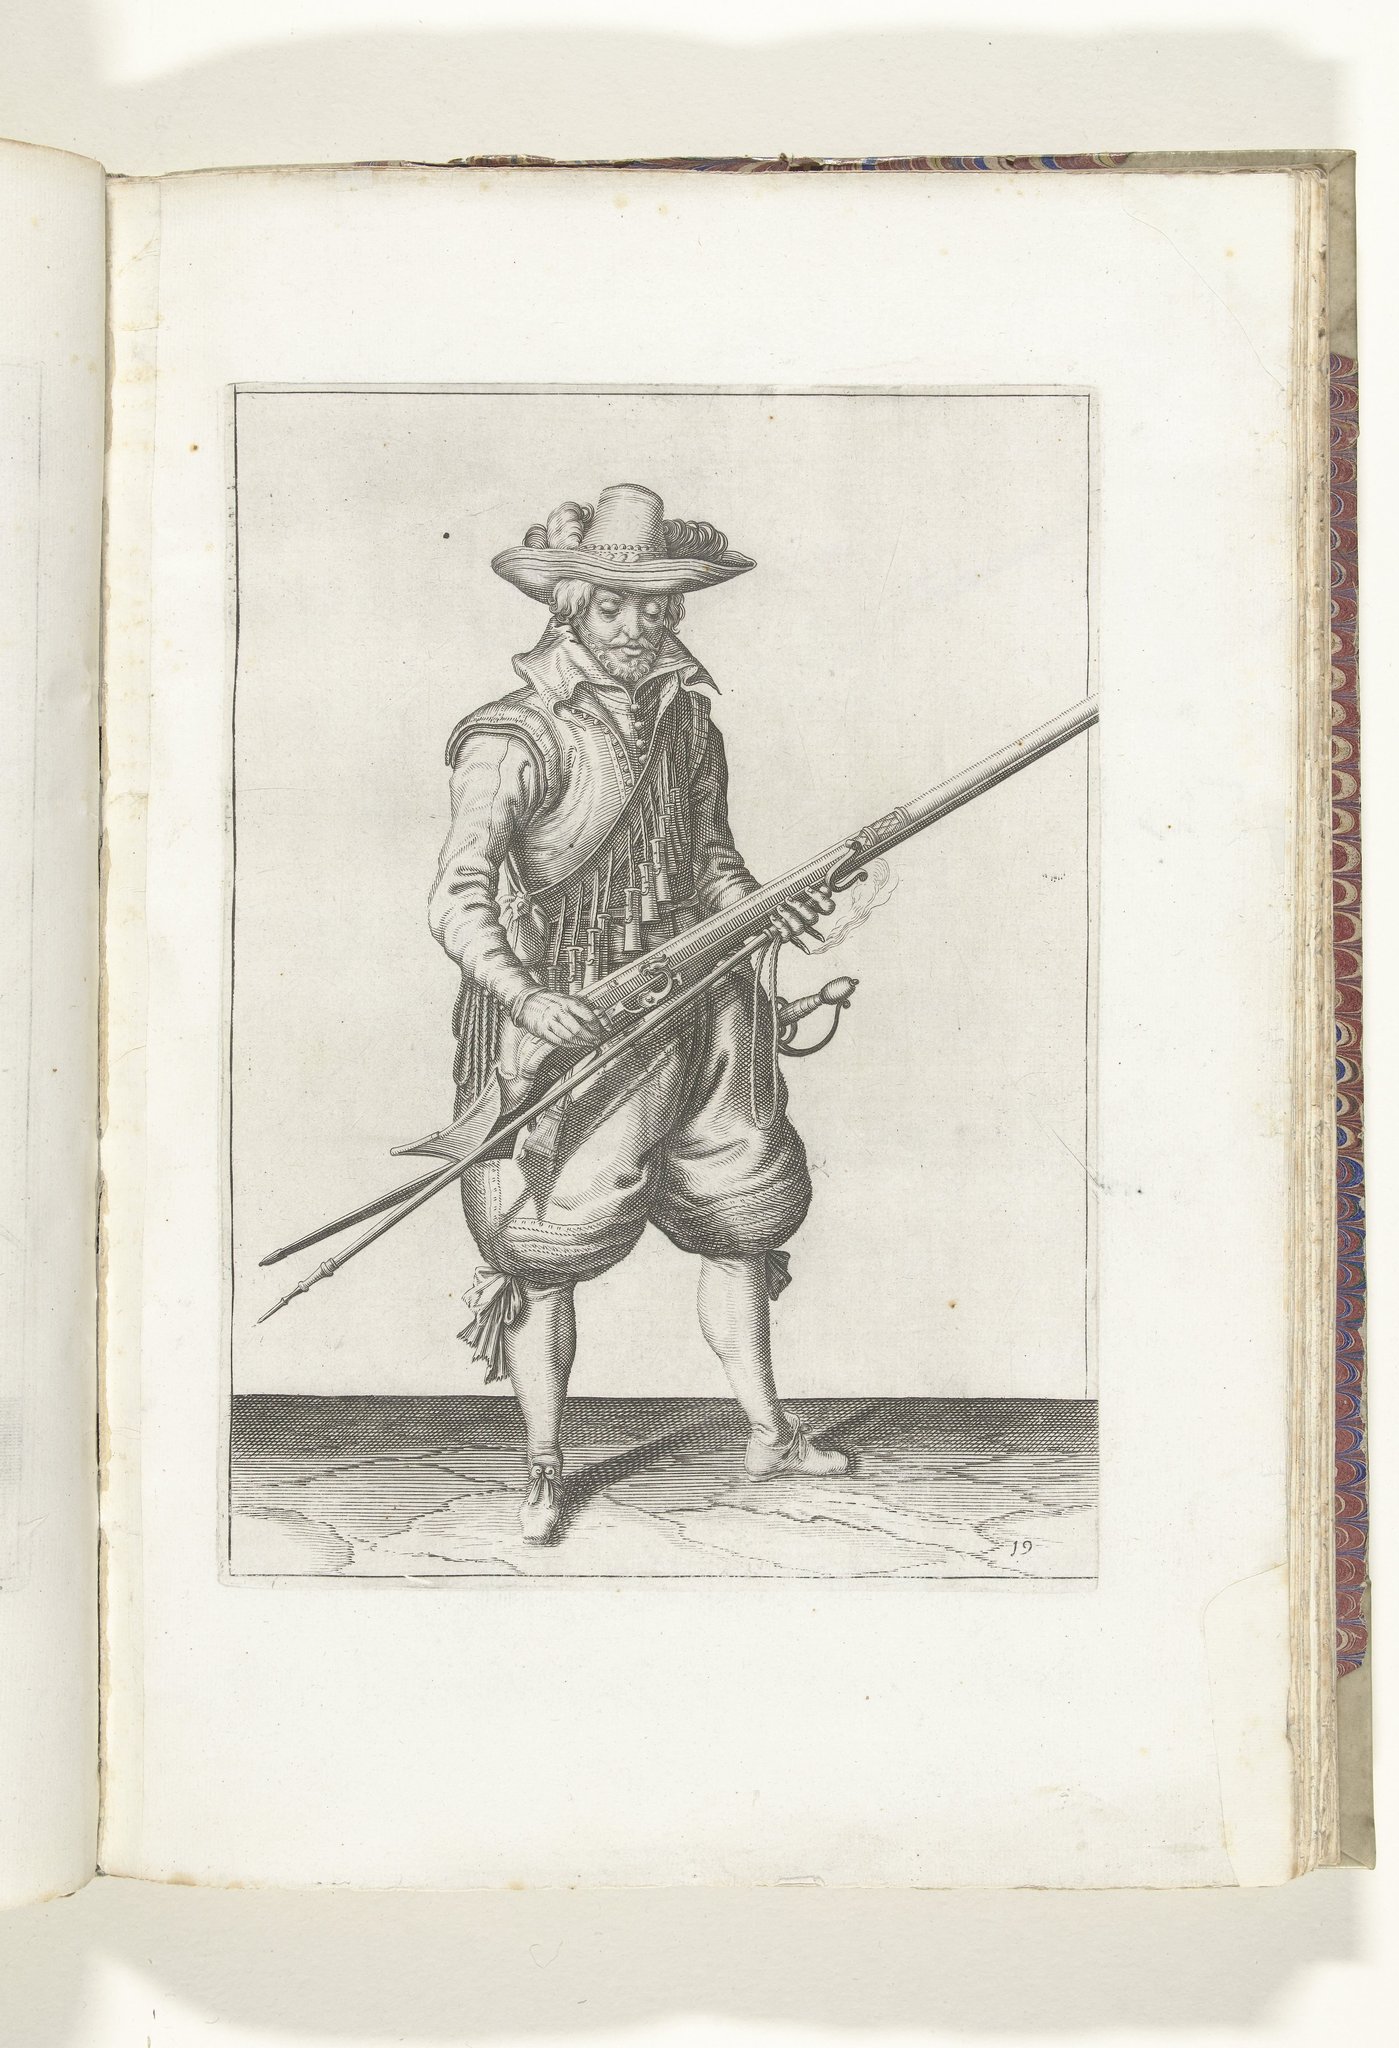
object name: print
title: Soldaat die kruit van zijn musket schudt (nr. 19), ca. 1600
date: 1597-1607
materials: paper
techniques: engraving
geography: amsterdam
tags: the hague, maurice (prince of orange), handling of weapons ~ military training, weapons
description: Een soldaat, ten voeten uit, naar rechts, die met beide handen een musket (een bepaald type vuurwapen) schudt, om eventueel buiten de pan (het kruitreservoir) gevallen kruit ervan af te krijgen (nr. 19), ca. 1600. In zijn linkerhand behalve de loop van het musket ook een furket (musketvork) en een brandende lont. Plaat 19 in de instructies voor het hanteren van het musket: Corte onderrechtinghe op de figuerlicke afbeeldinghe, soo veel aengaet het recht ghebruyck van Musquet. Onderdeel van de illustraties in: J. de Gheyn, Wapenhandelinghe van Roers Musquetten ende spiessen, Amsterdam, 1608. Krijgswezen rond 1600.